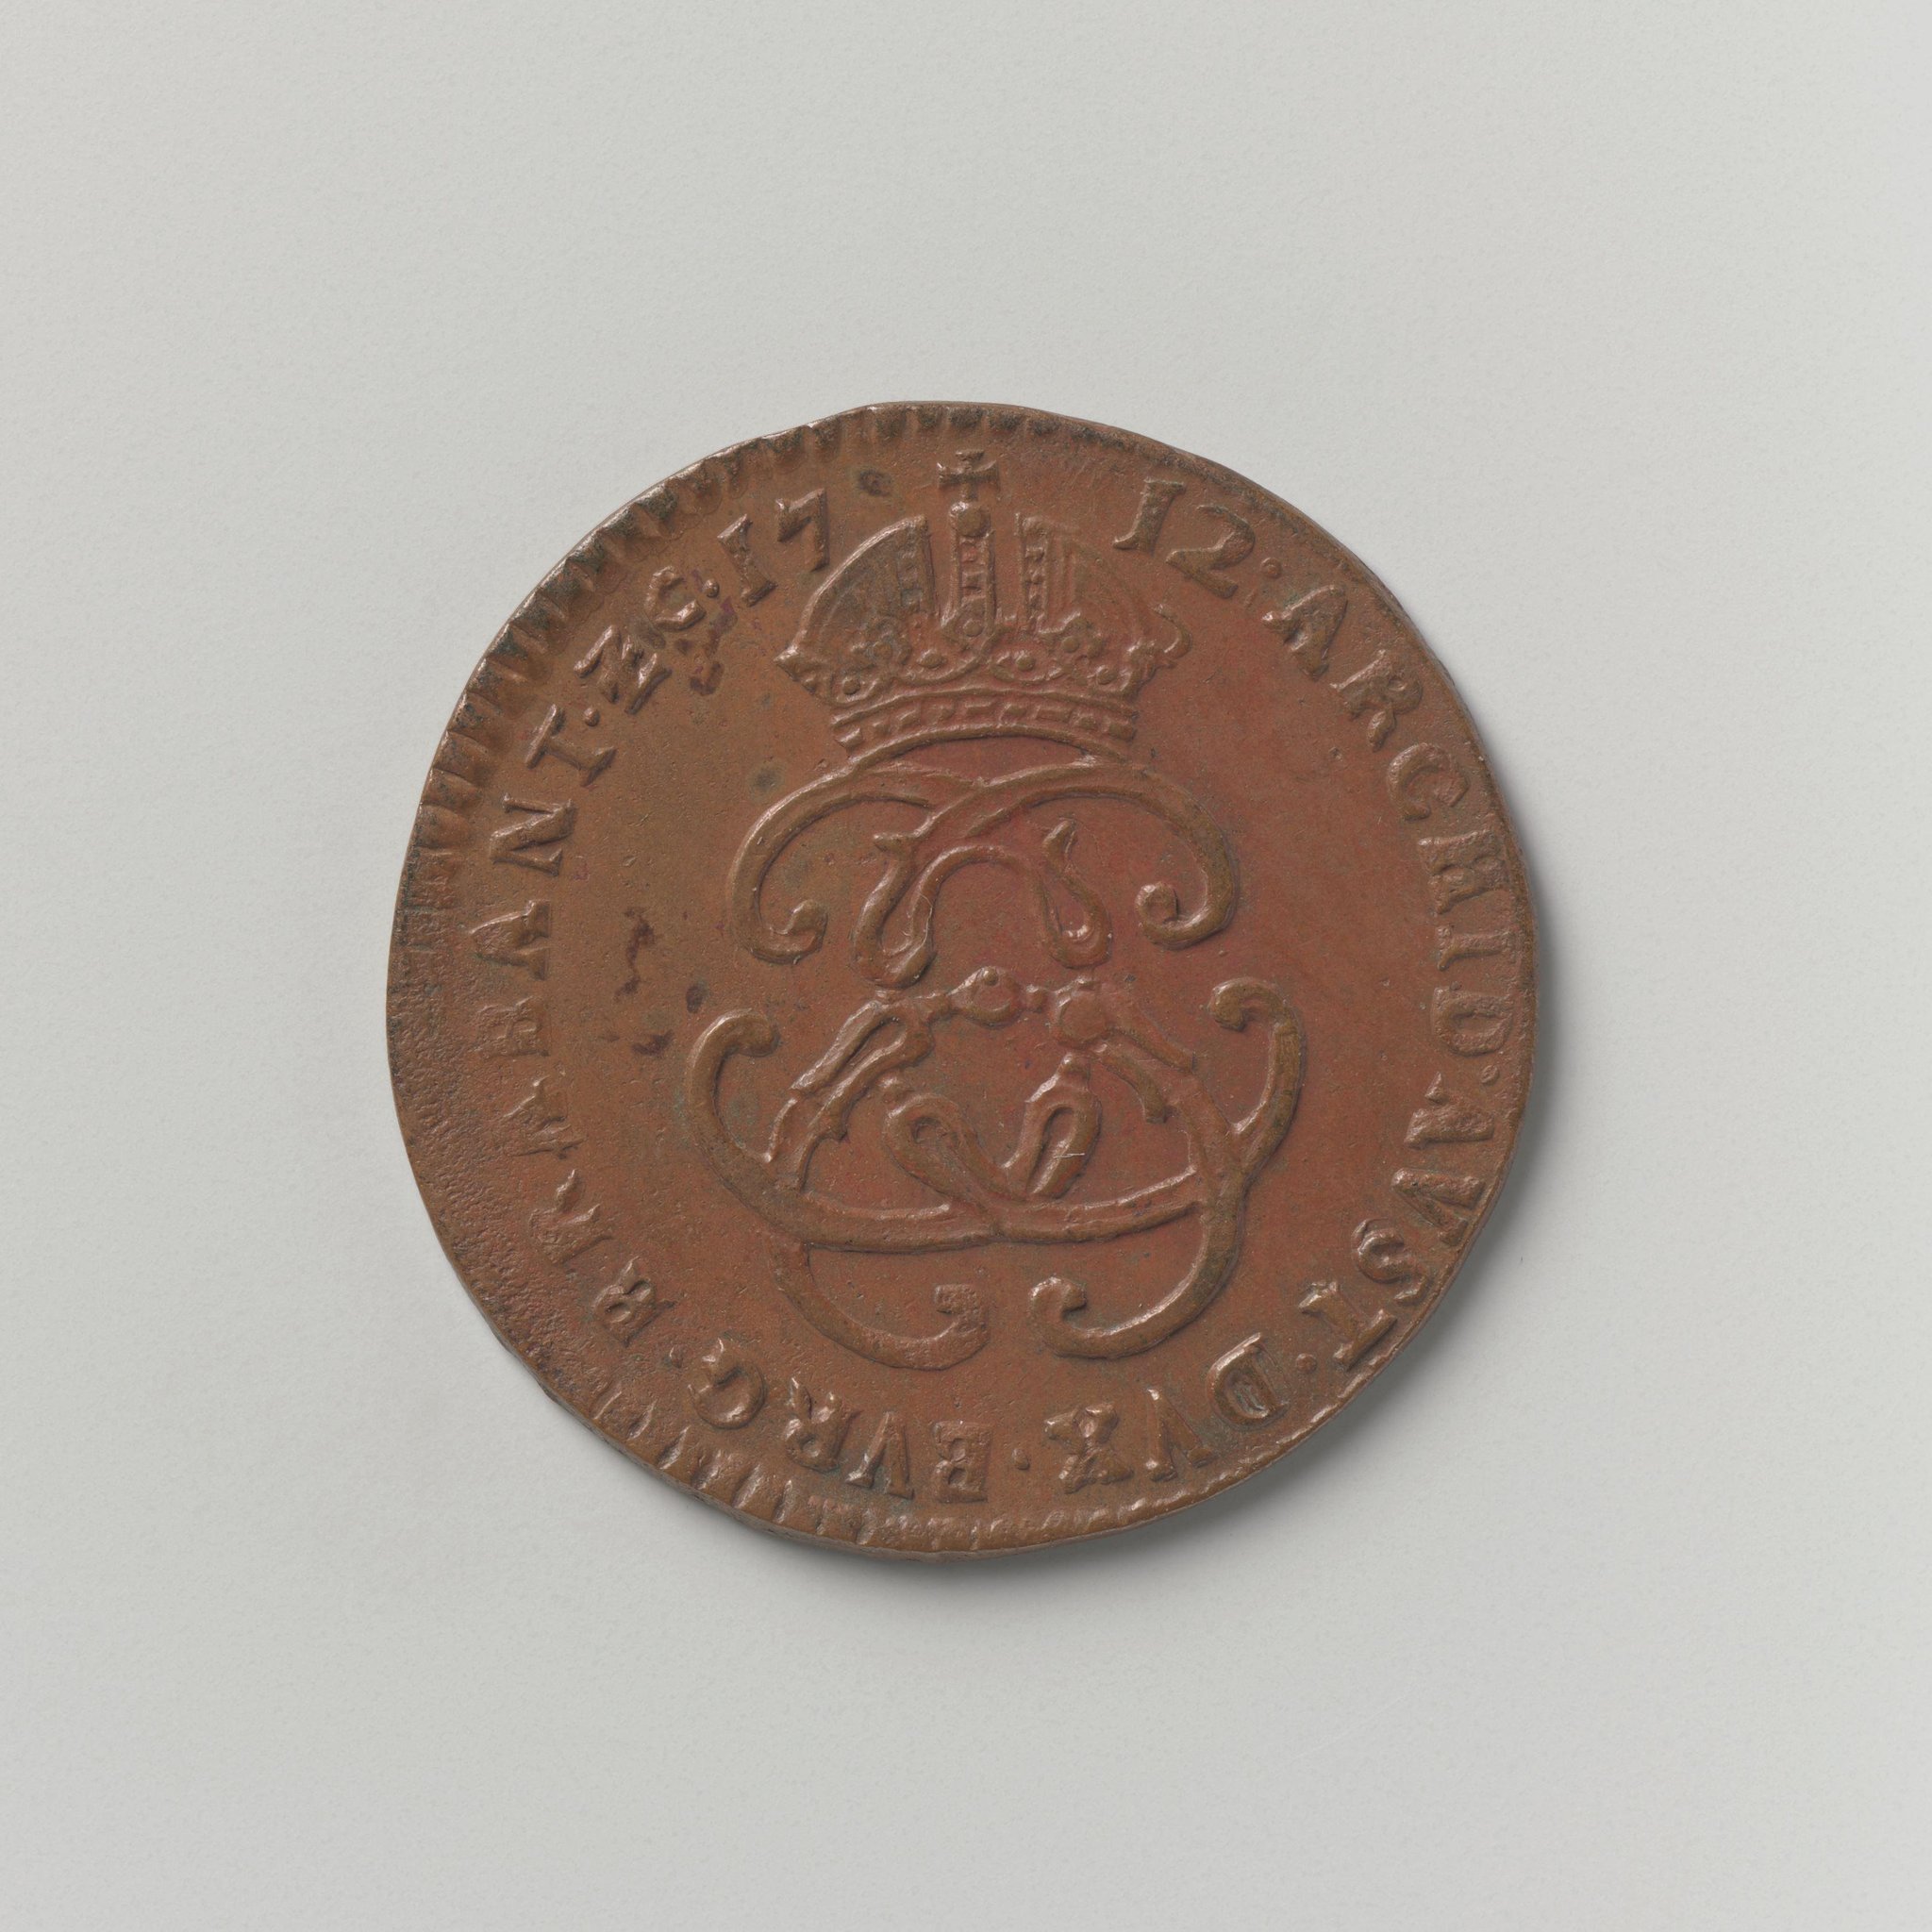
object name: oord, oortje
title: Oord uit Brabant van Karel VI, 1712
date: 1712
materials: copper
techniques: striking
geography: antwerp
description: Koperen munt. Voorzijde: portret van Karel VI naar links. Hand onder portret. Keerzijde: gekroond monogram. Jaartal rondom kroon.